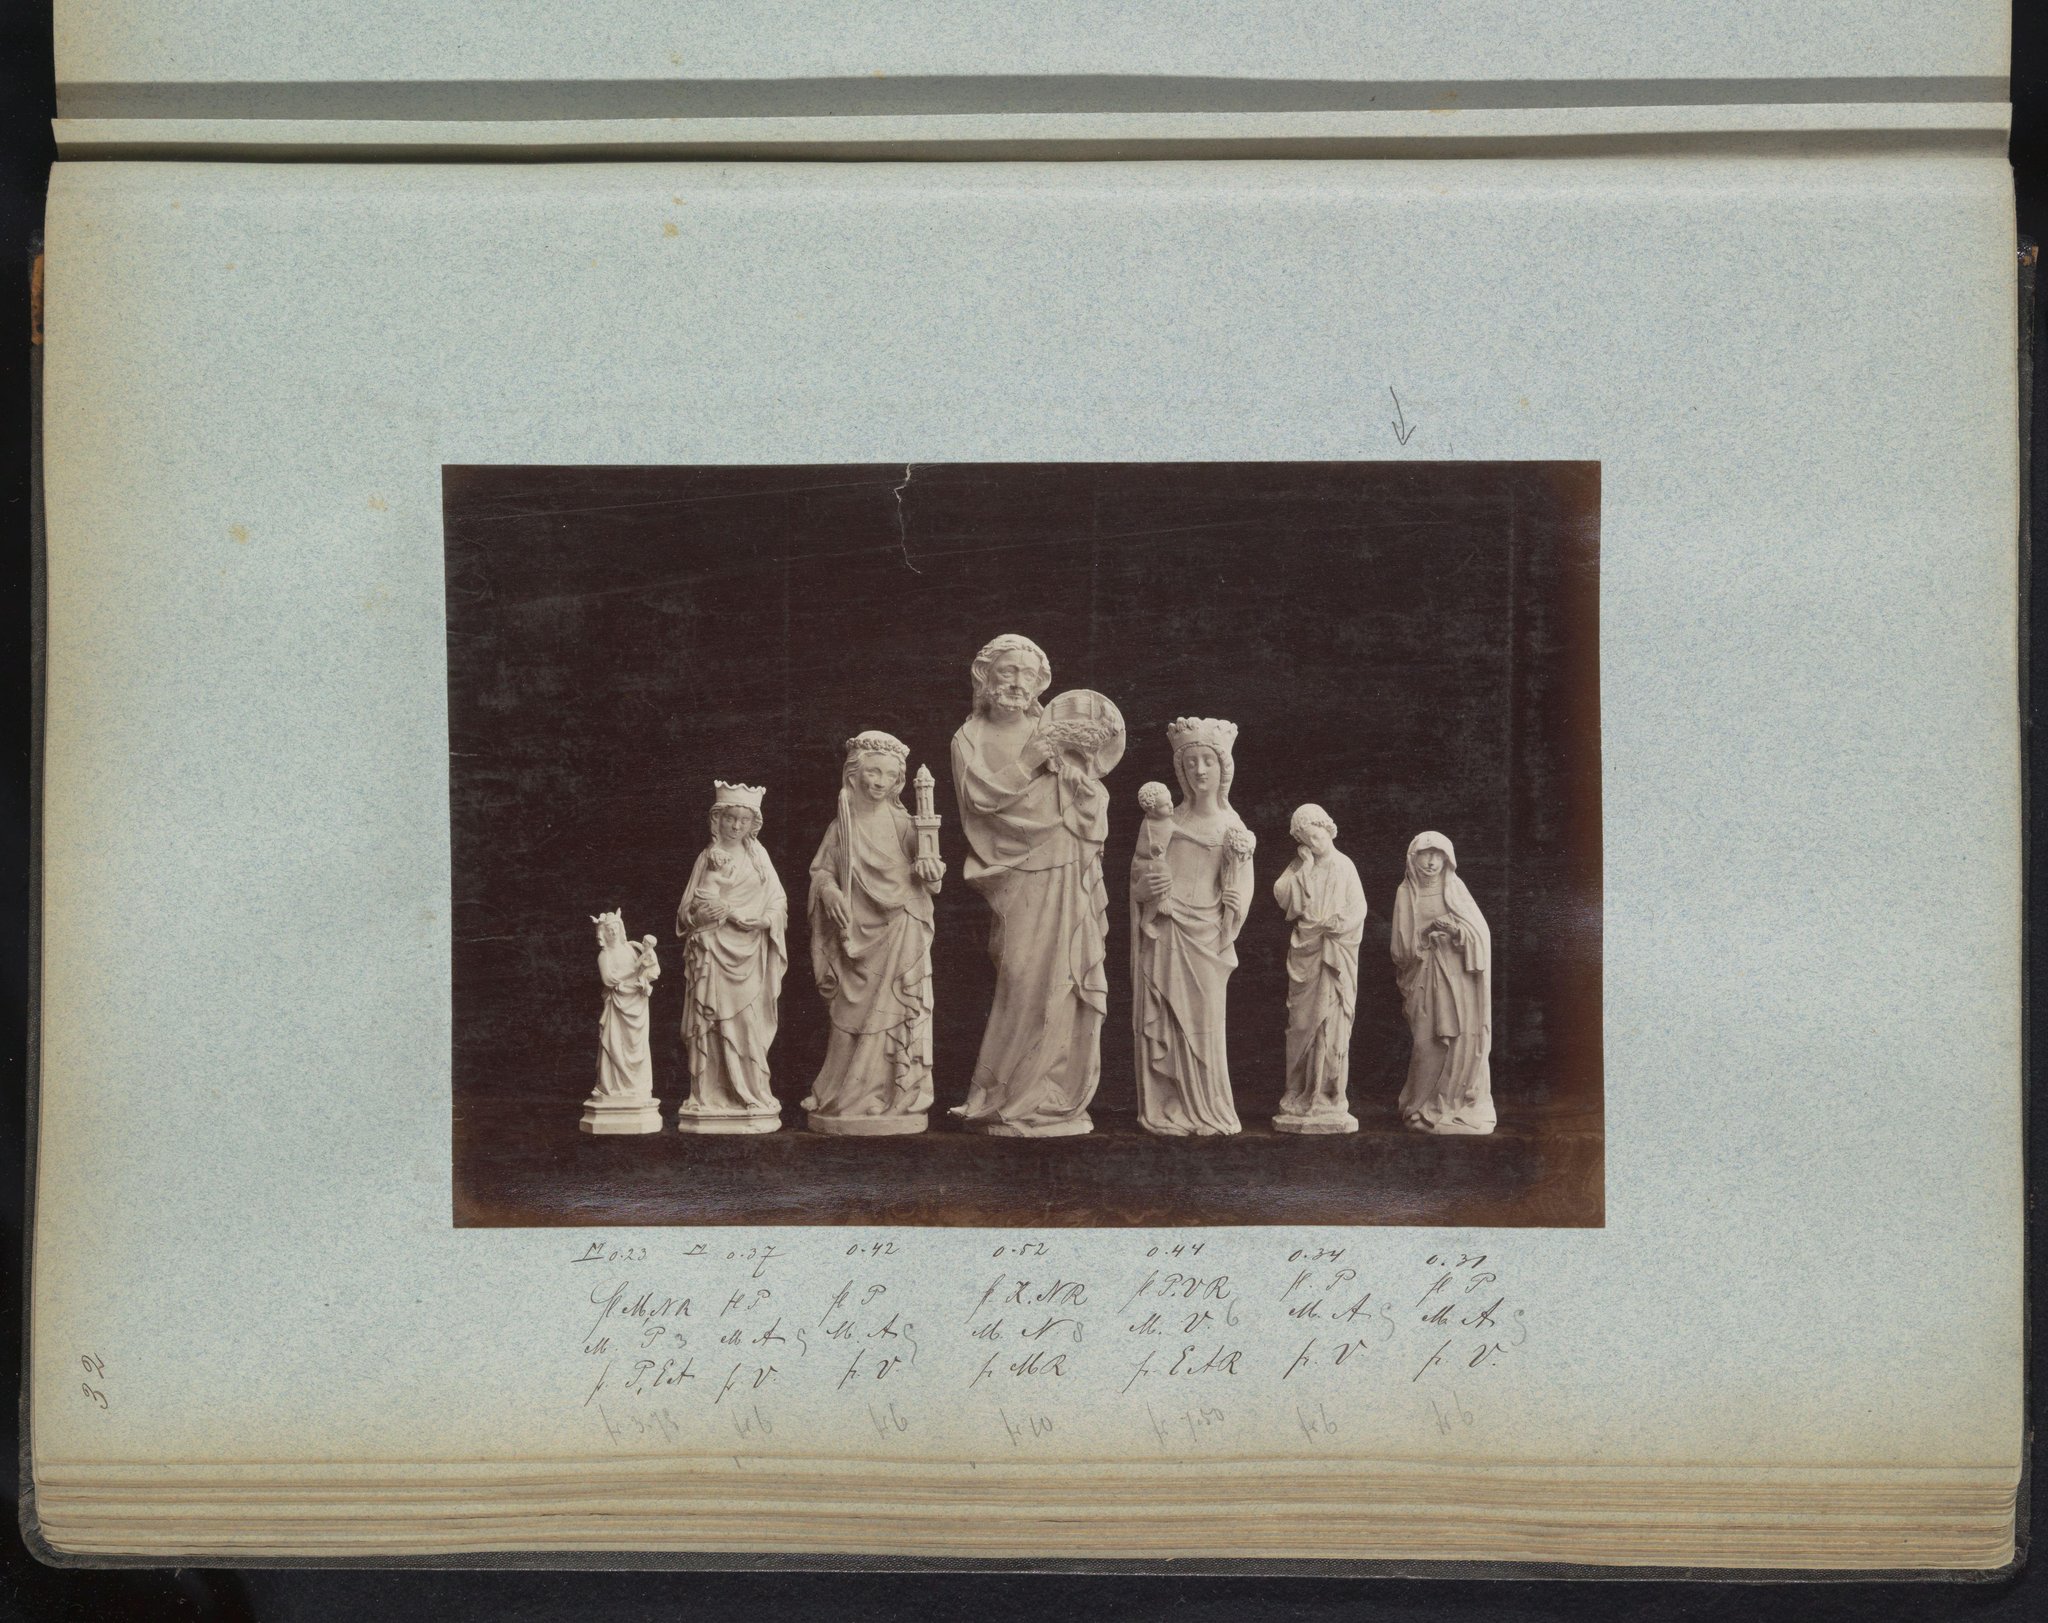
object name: photograph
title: Zeven gipsen afgietsels van religieuze sculpturen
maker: Anonymous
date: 1875-1900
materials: paper, photographic support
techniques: albumen print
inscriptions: annotation, annotation: ‘M 0.23 M 0.37 M 0.42 M 0.52 M 0.44 M 34 M 0.31’